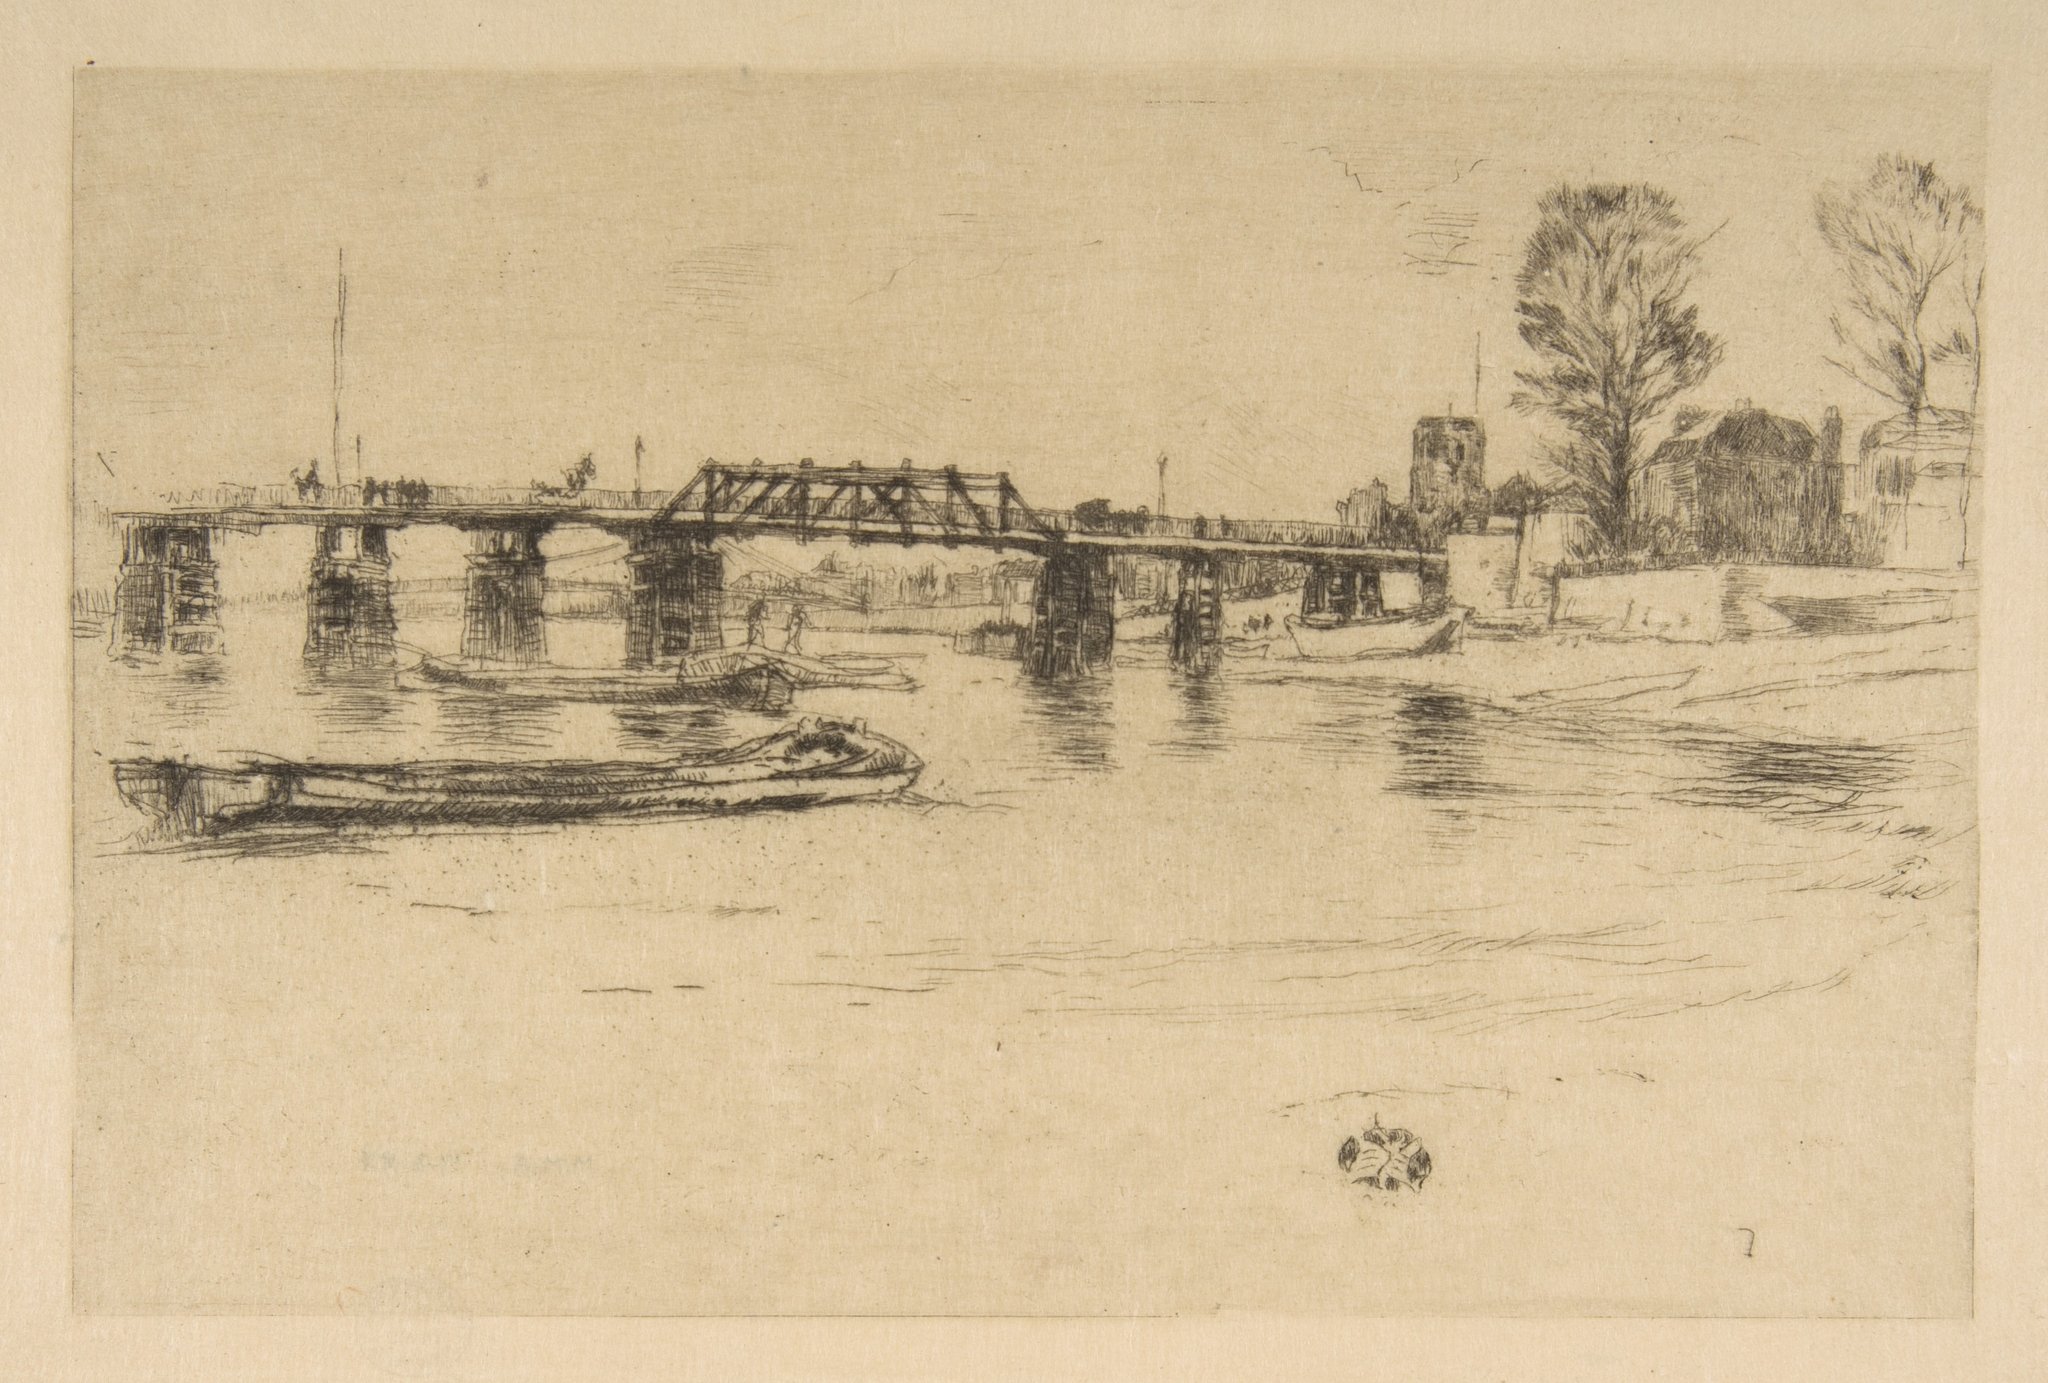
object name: print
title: Fulham (Chelsea)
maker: james mcneill whistler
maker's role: artist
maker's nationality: american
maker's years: 1834-1903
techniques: etching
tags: bridges,rivers,boats